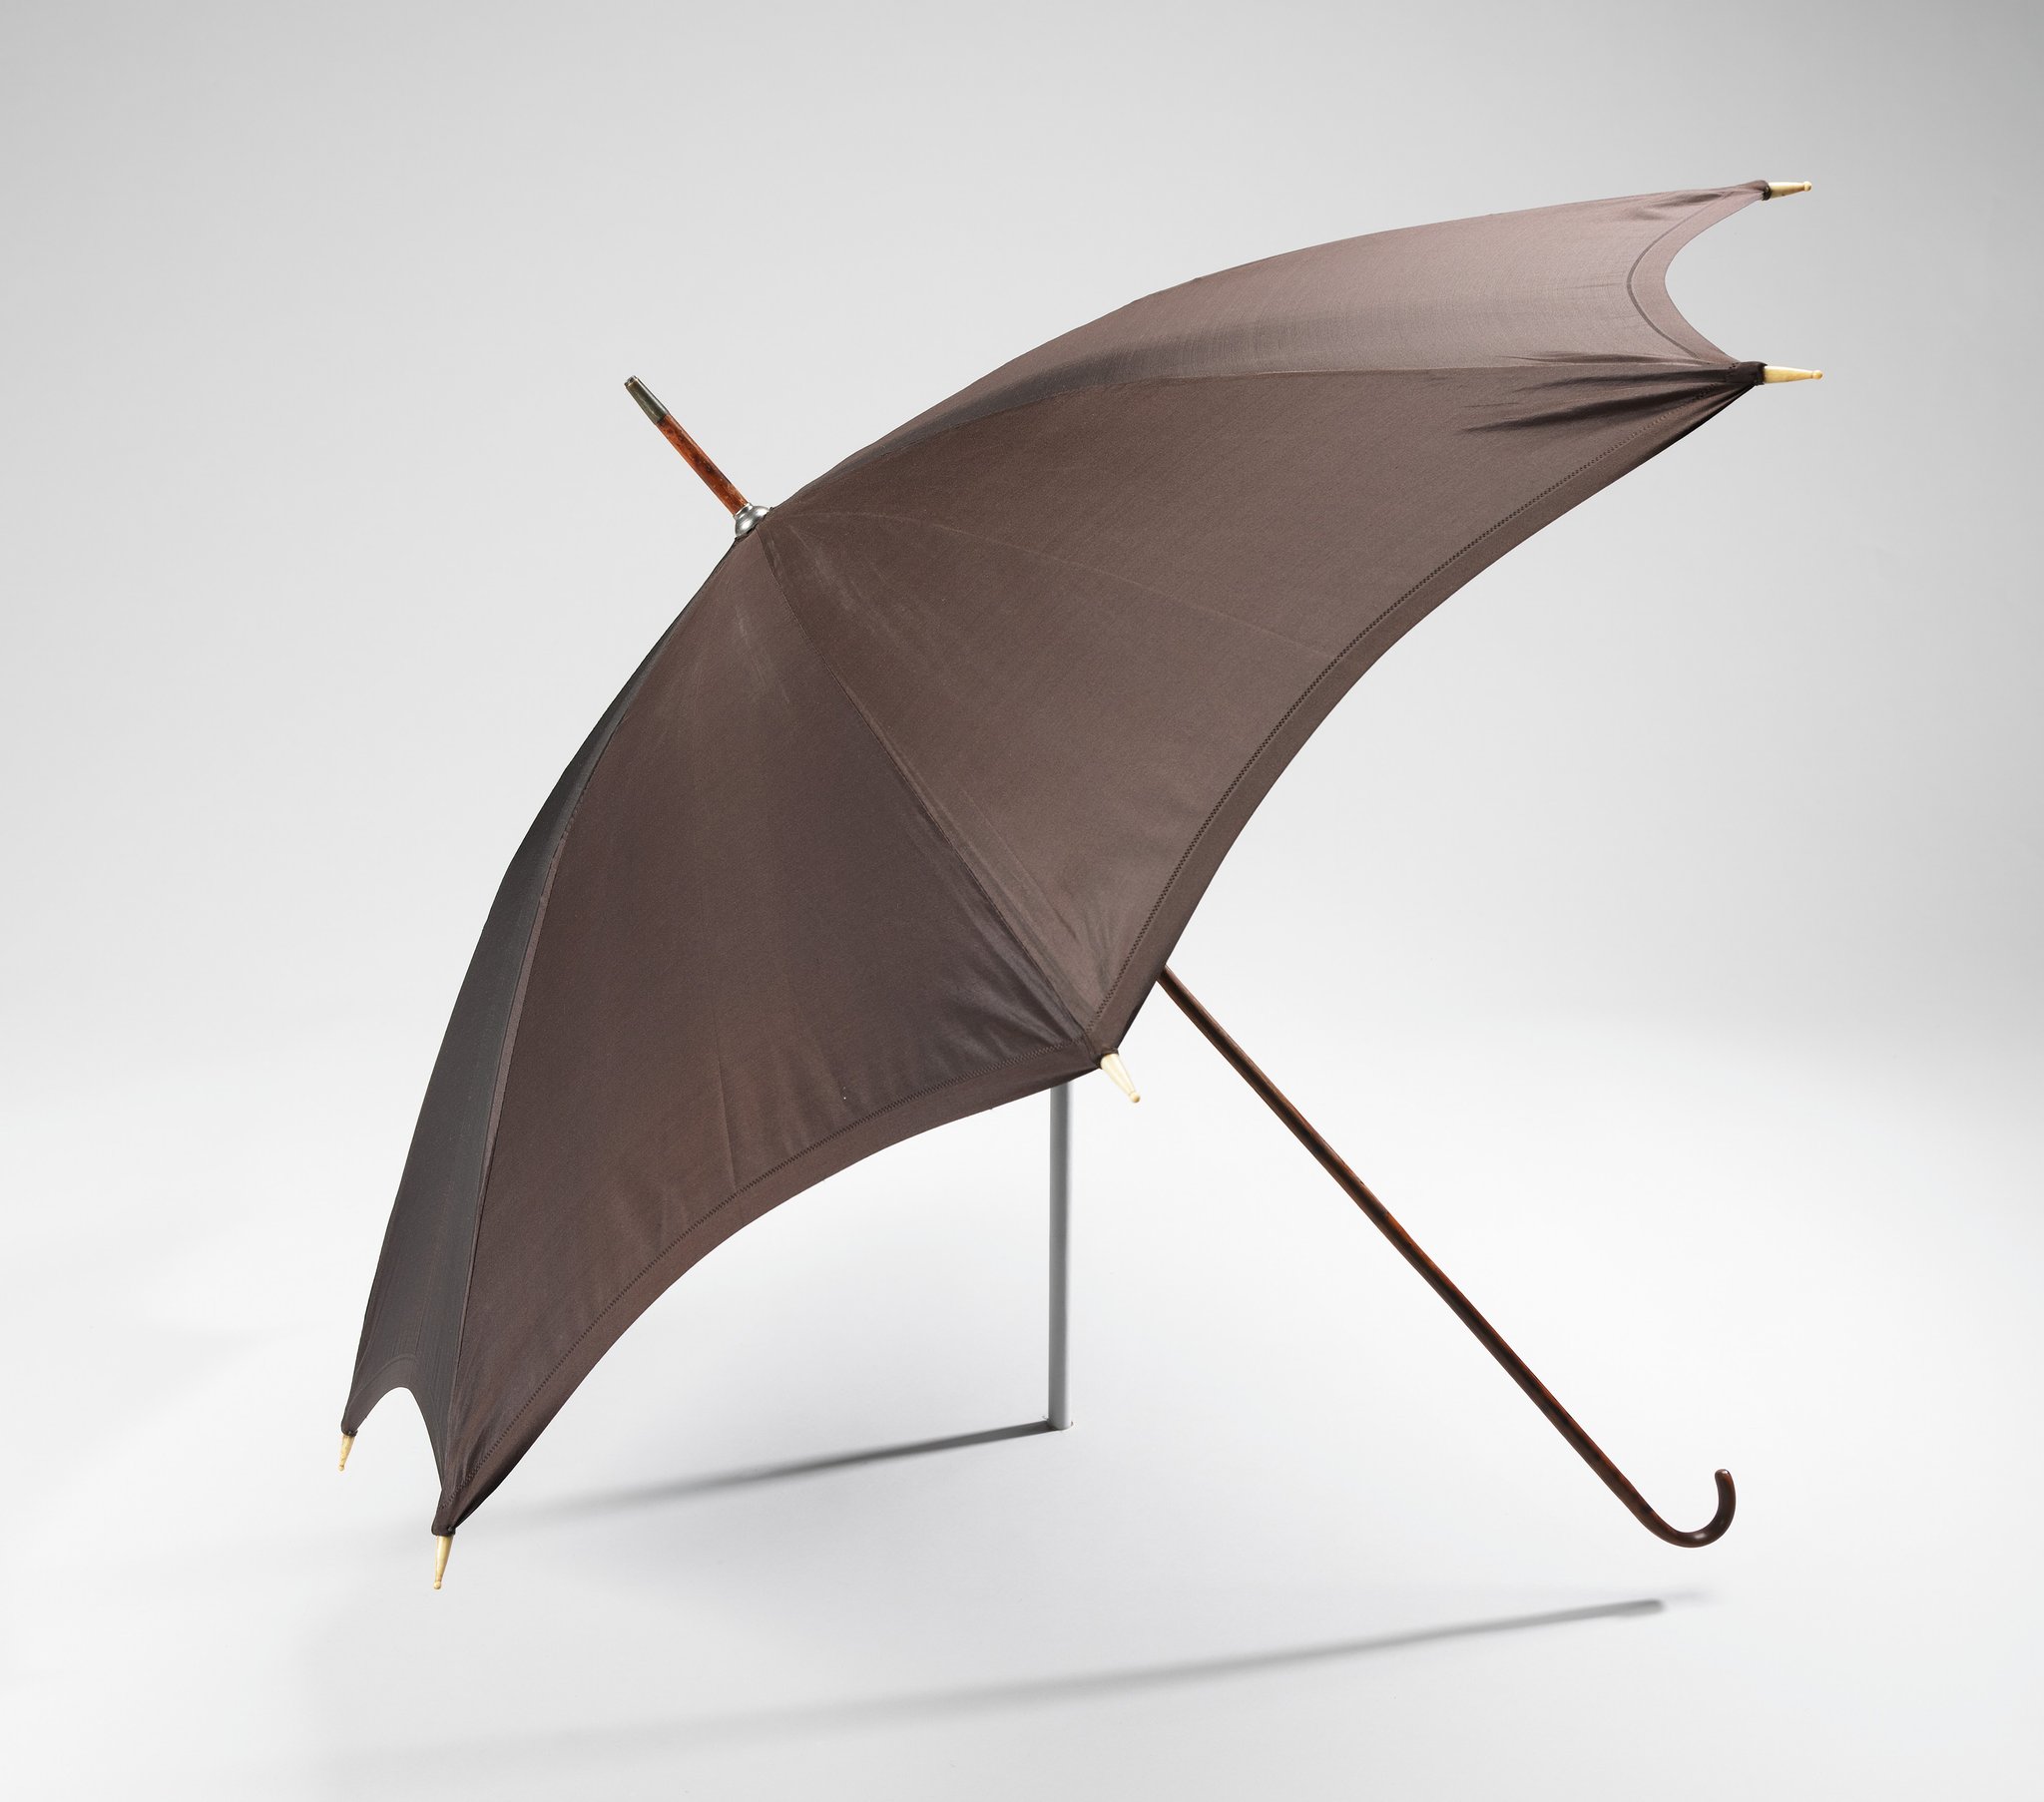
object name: parasol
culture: american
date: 1790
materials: ivory, metal, silk, wood